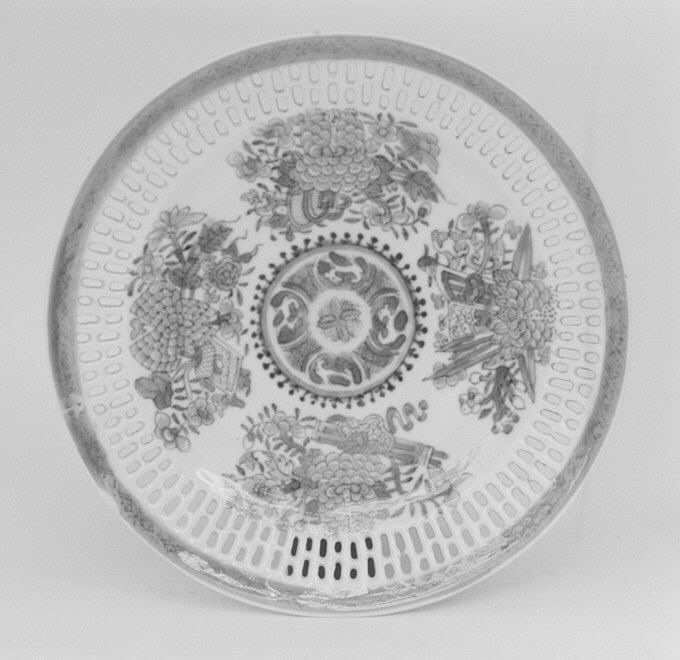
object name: plate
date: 1801-1833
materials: hard paste porcelain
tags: fruit,flowers